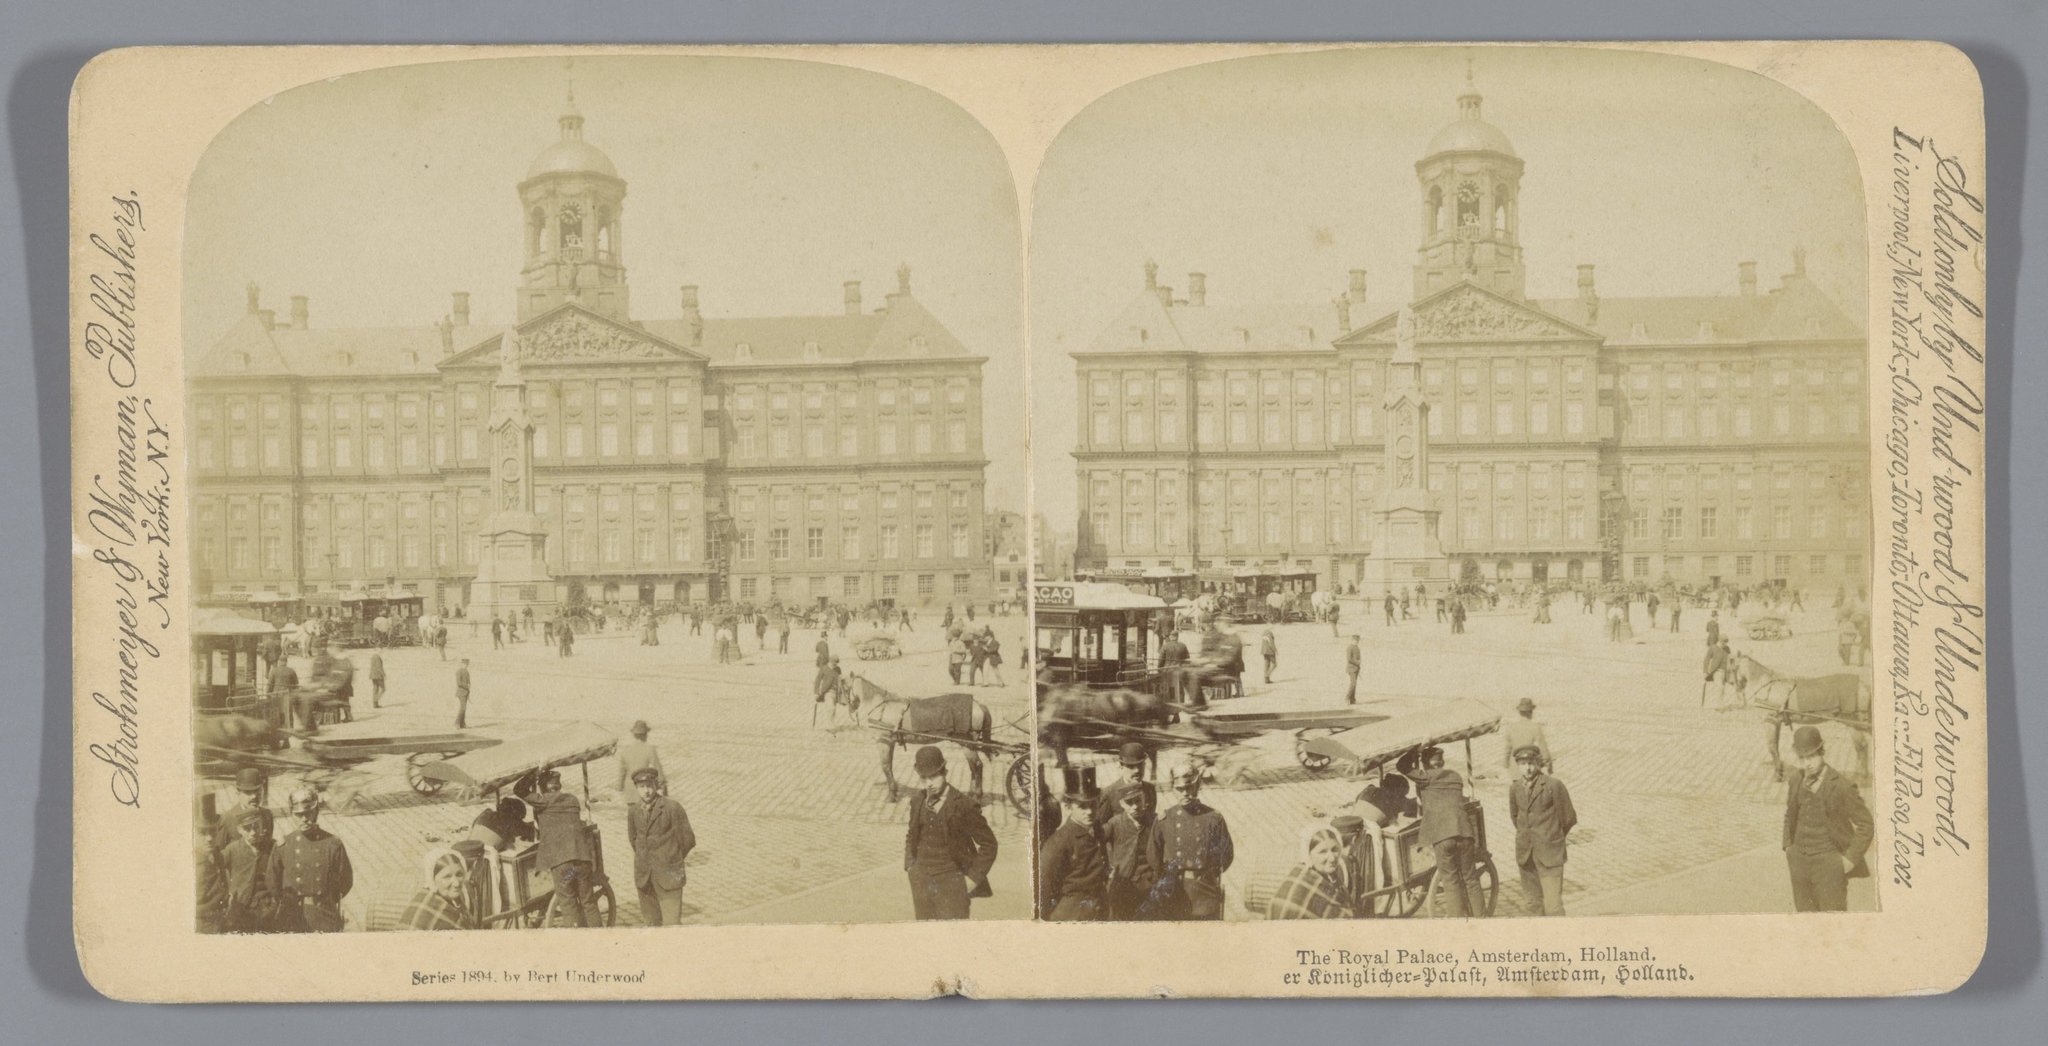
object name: stereograph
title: Koninklijk Paleis op de Dam, Amsterdam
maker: bert elias underwood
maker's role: fotograaf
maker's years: 1862-1943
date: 1894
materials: cardboard, paper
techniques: albumen print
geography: new york city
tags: square, place, circus, etc., palace, royal palace of amsterdam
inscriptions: inscription: ‘1.’